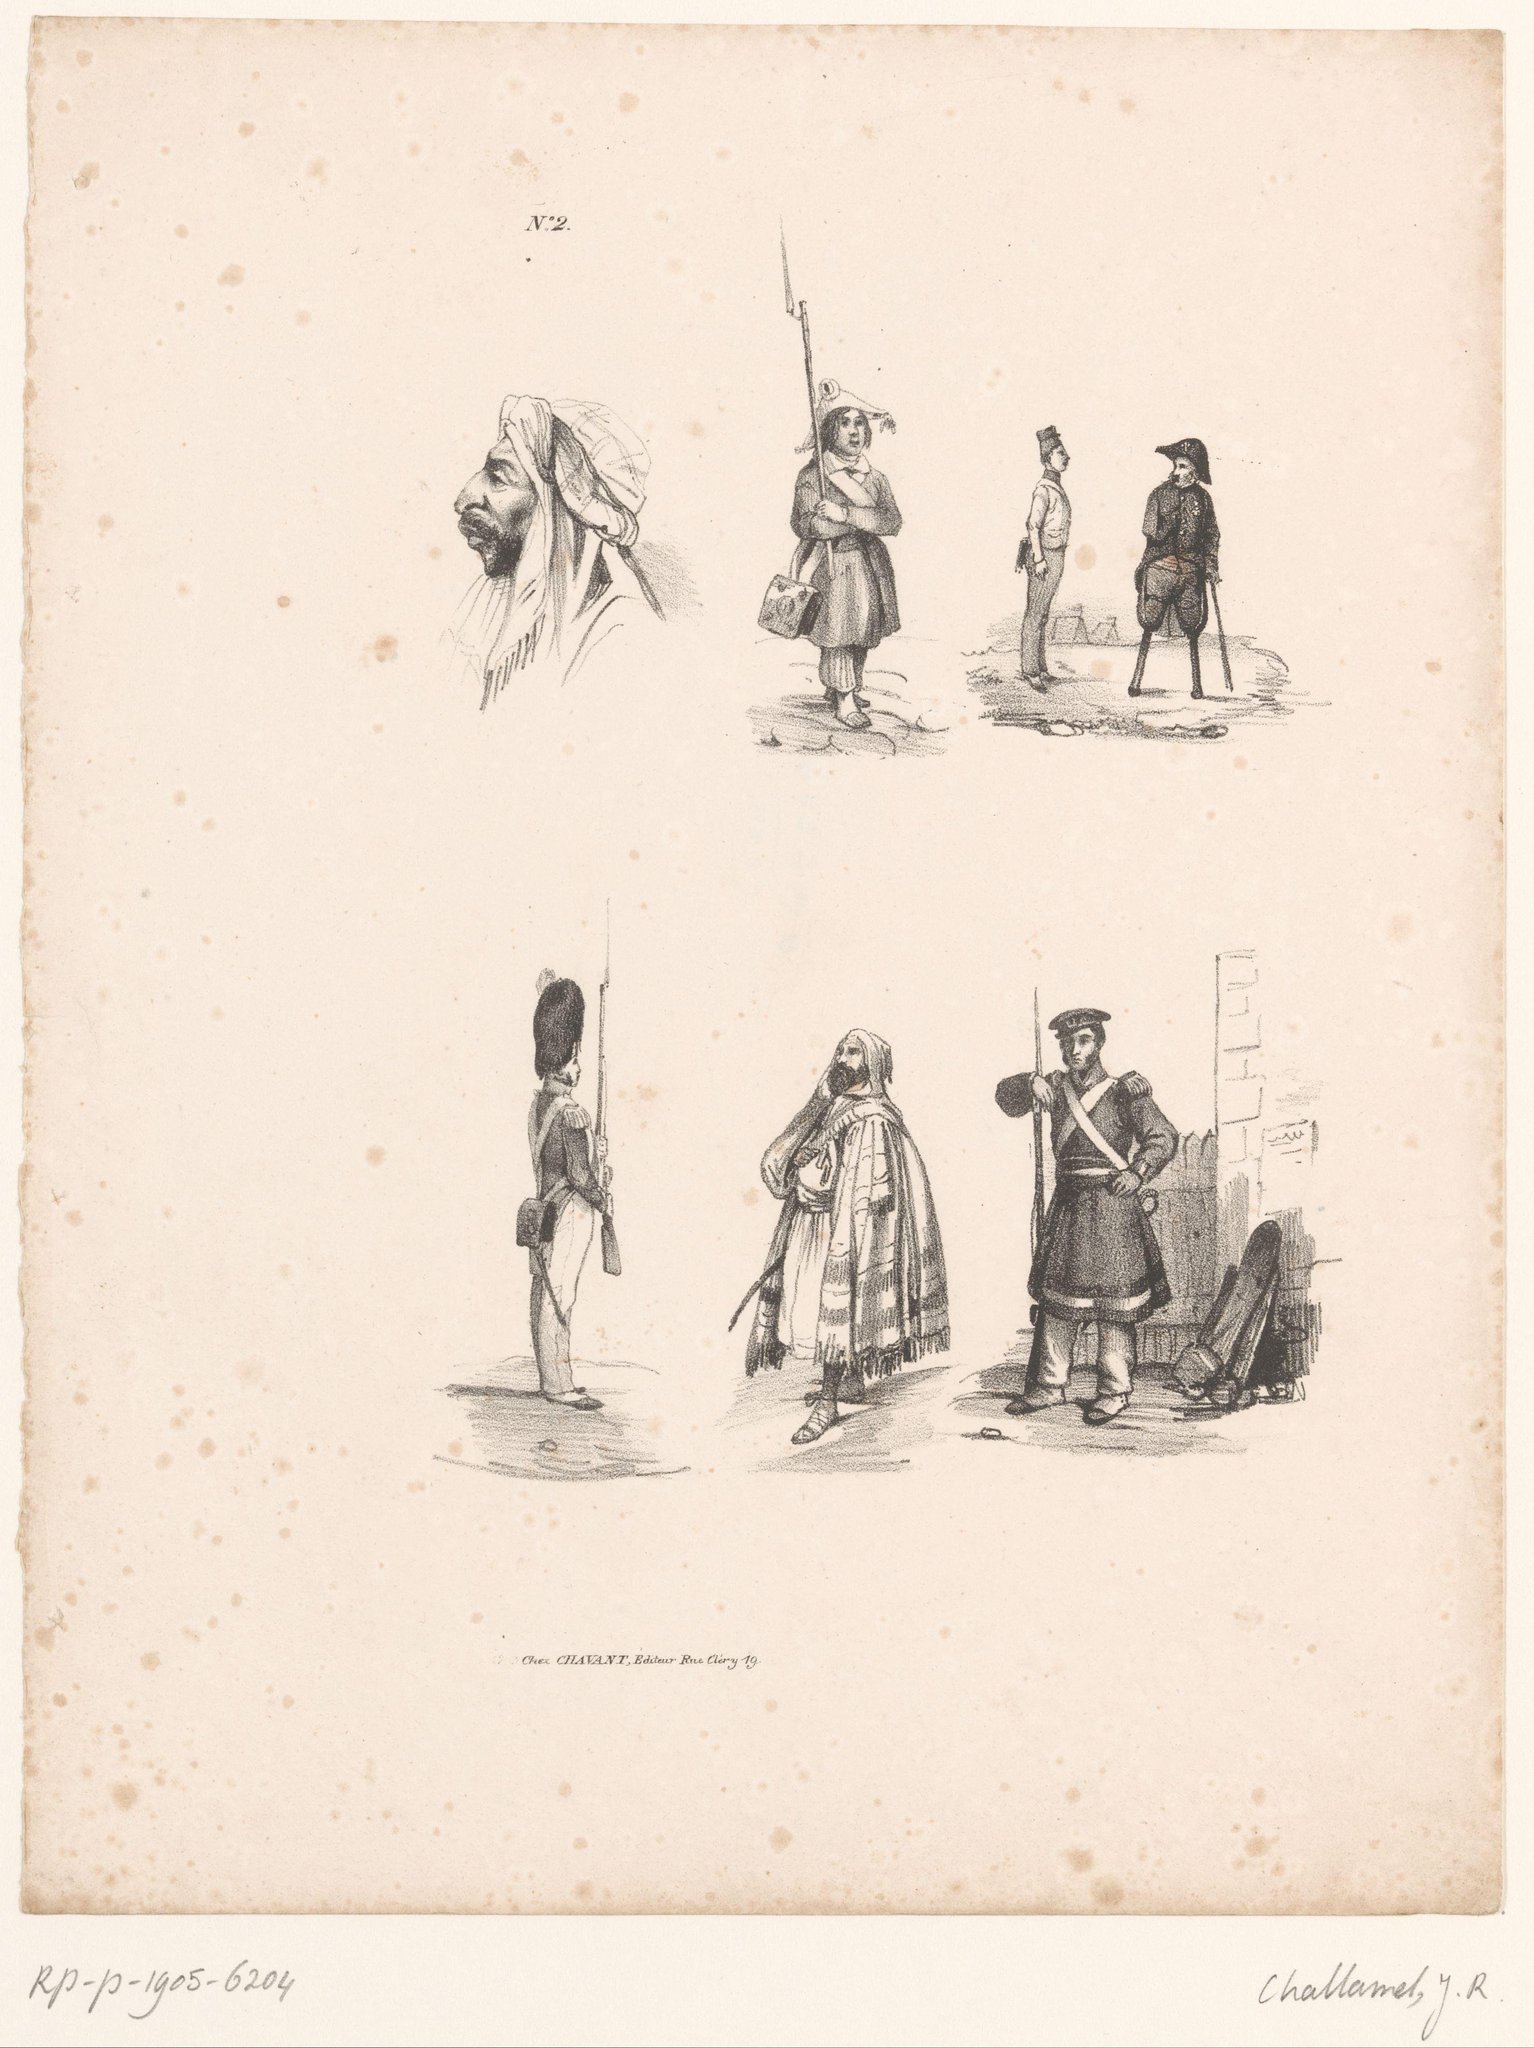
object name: print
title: Zes studies van soldaten, Arabieren en veteranen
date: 1829-1841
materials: paper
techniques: lithograph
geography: paris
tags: human types; peoples and nationalities, veteran, private soldier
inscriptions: collector's mark: Lugt 2228a